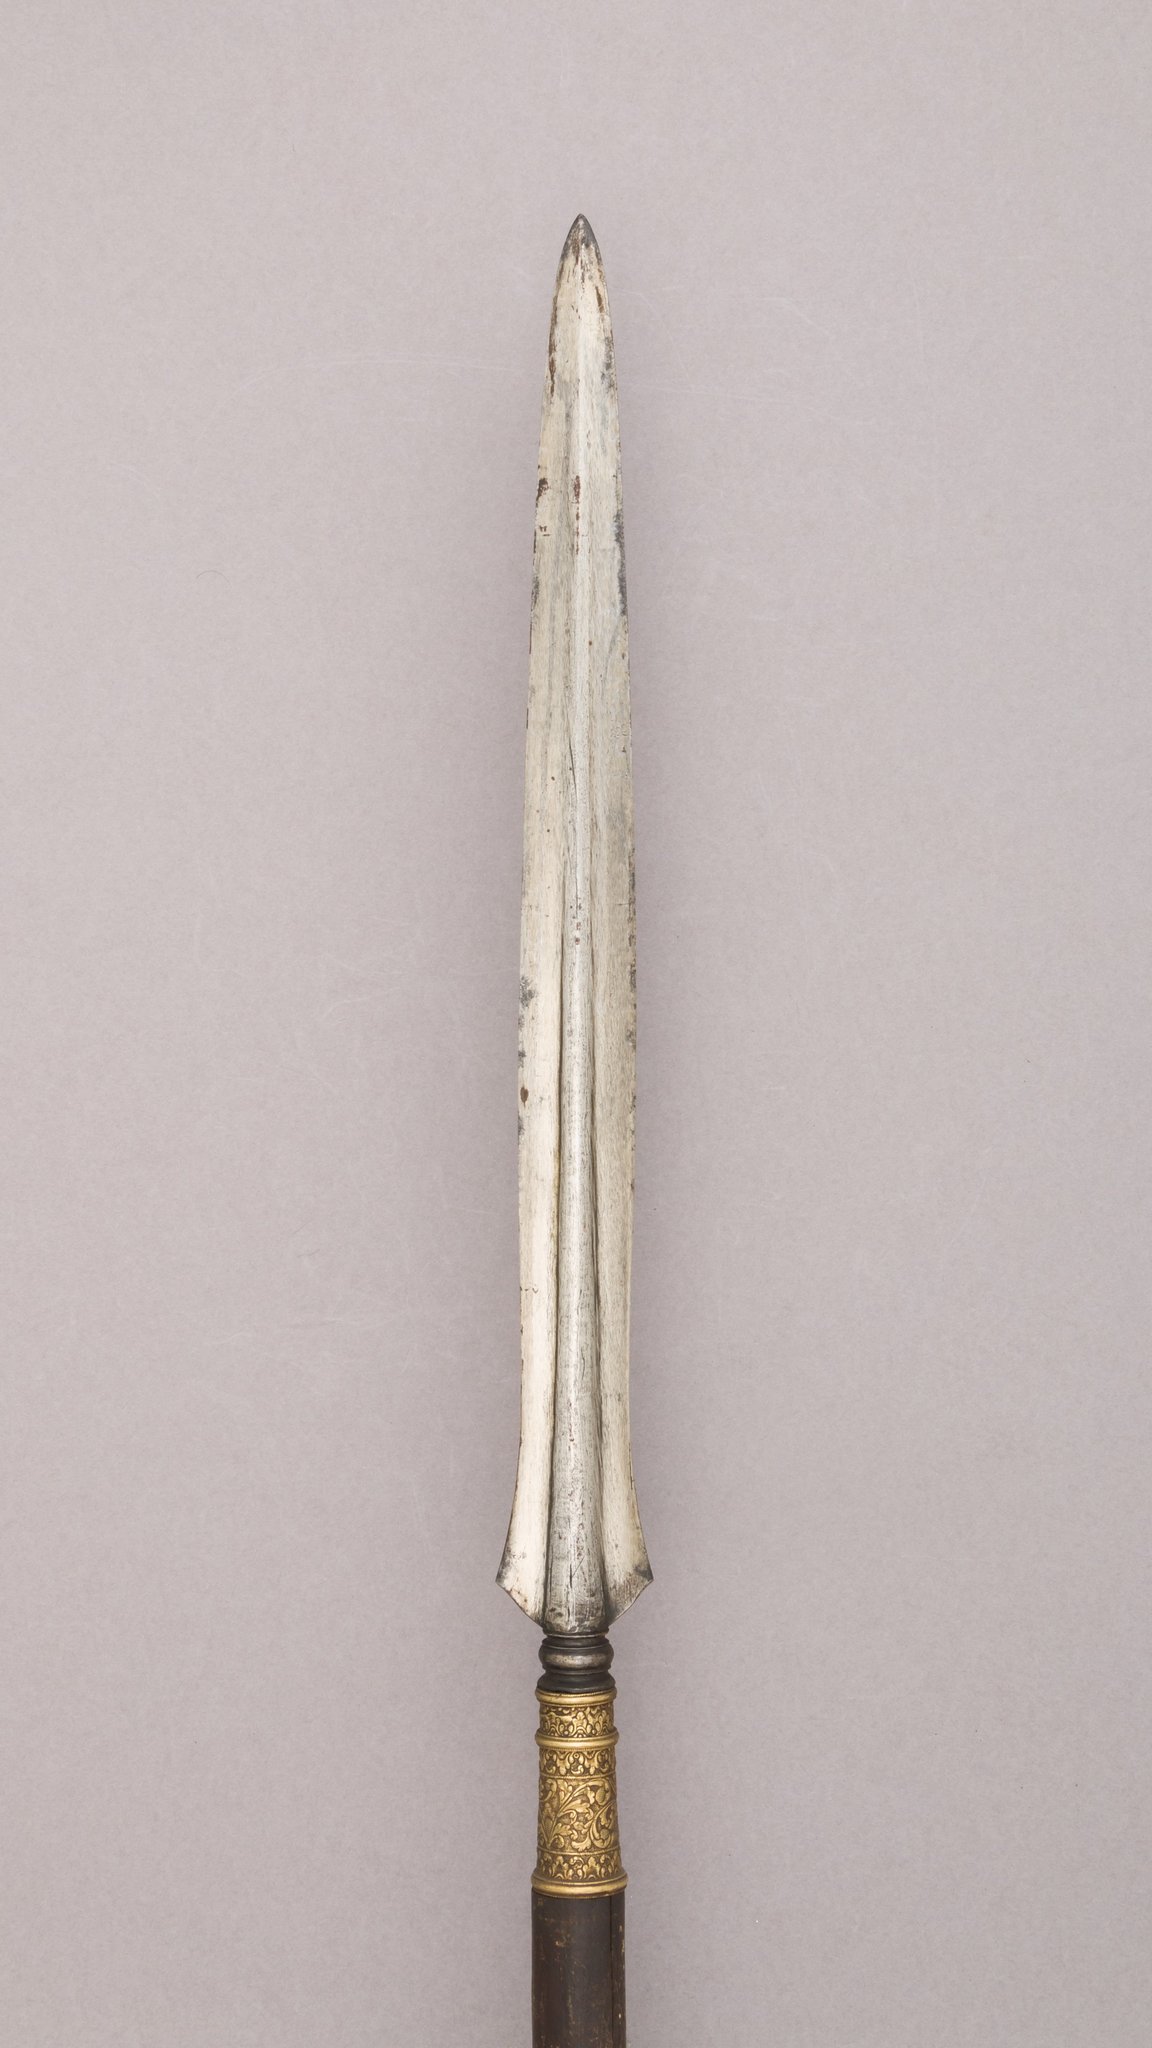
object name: spear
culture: javanese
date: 1501-1900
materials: gold, steel, wood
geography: indonesia